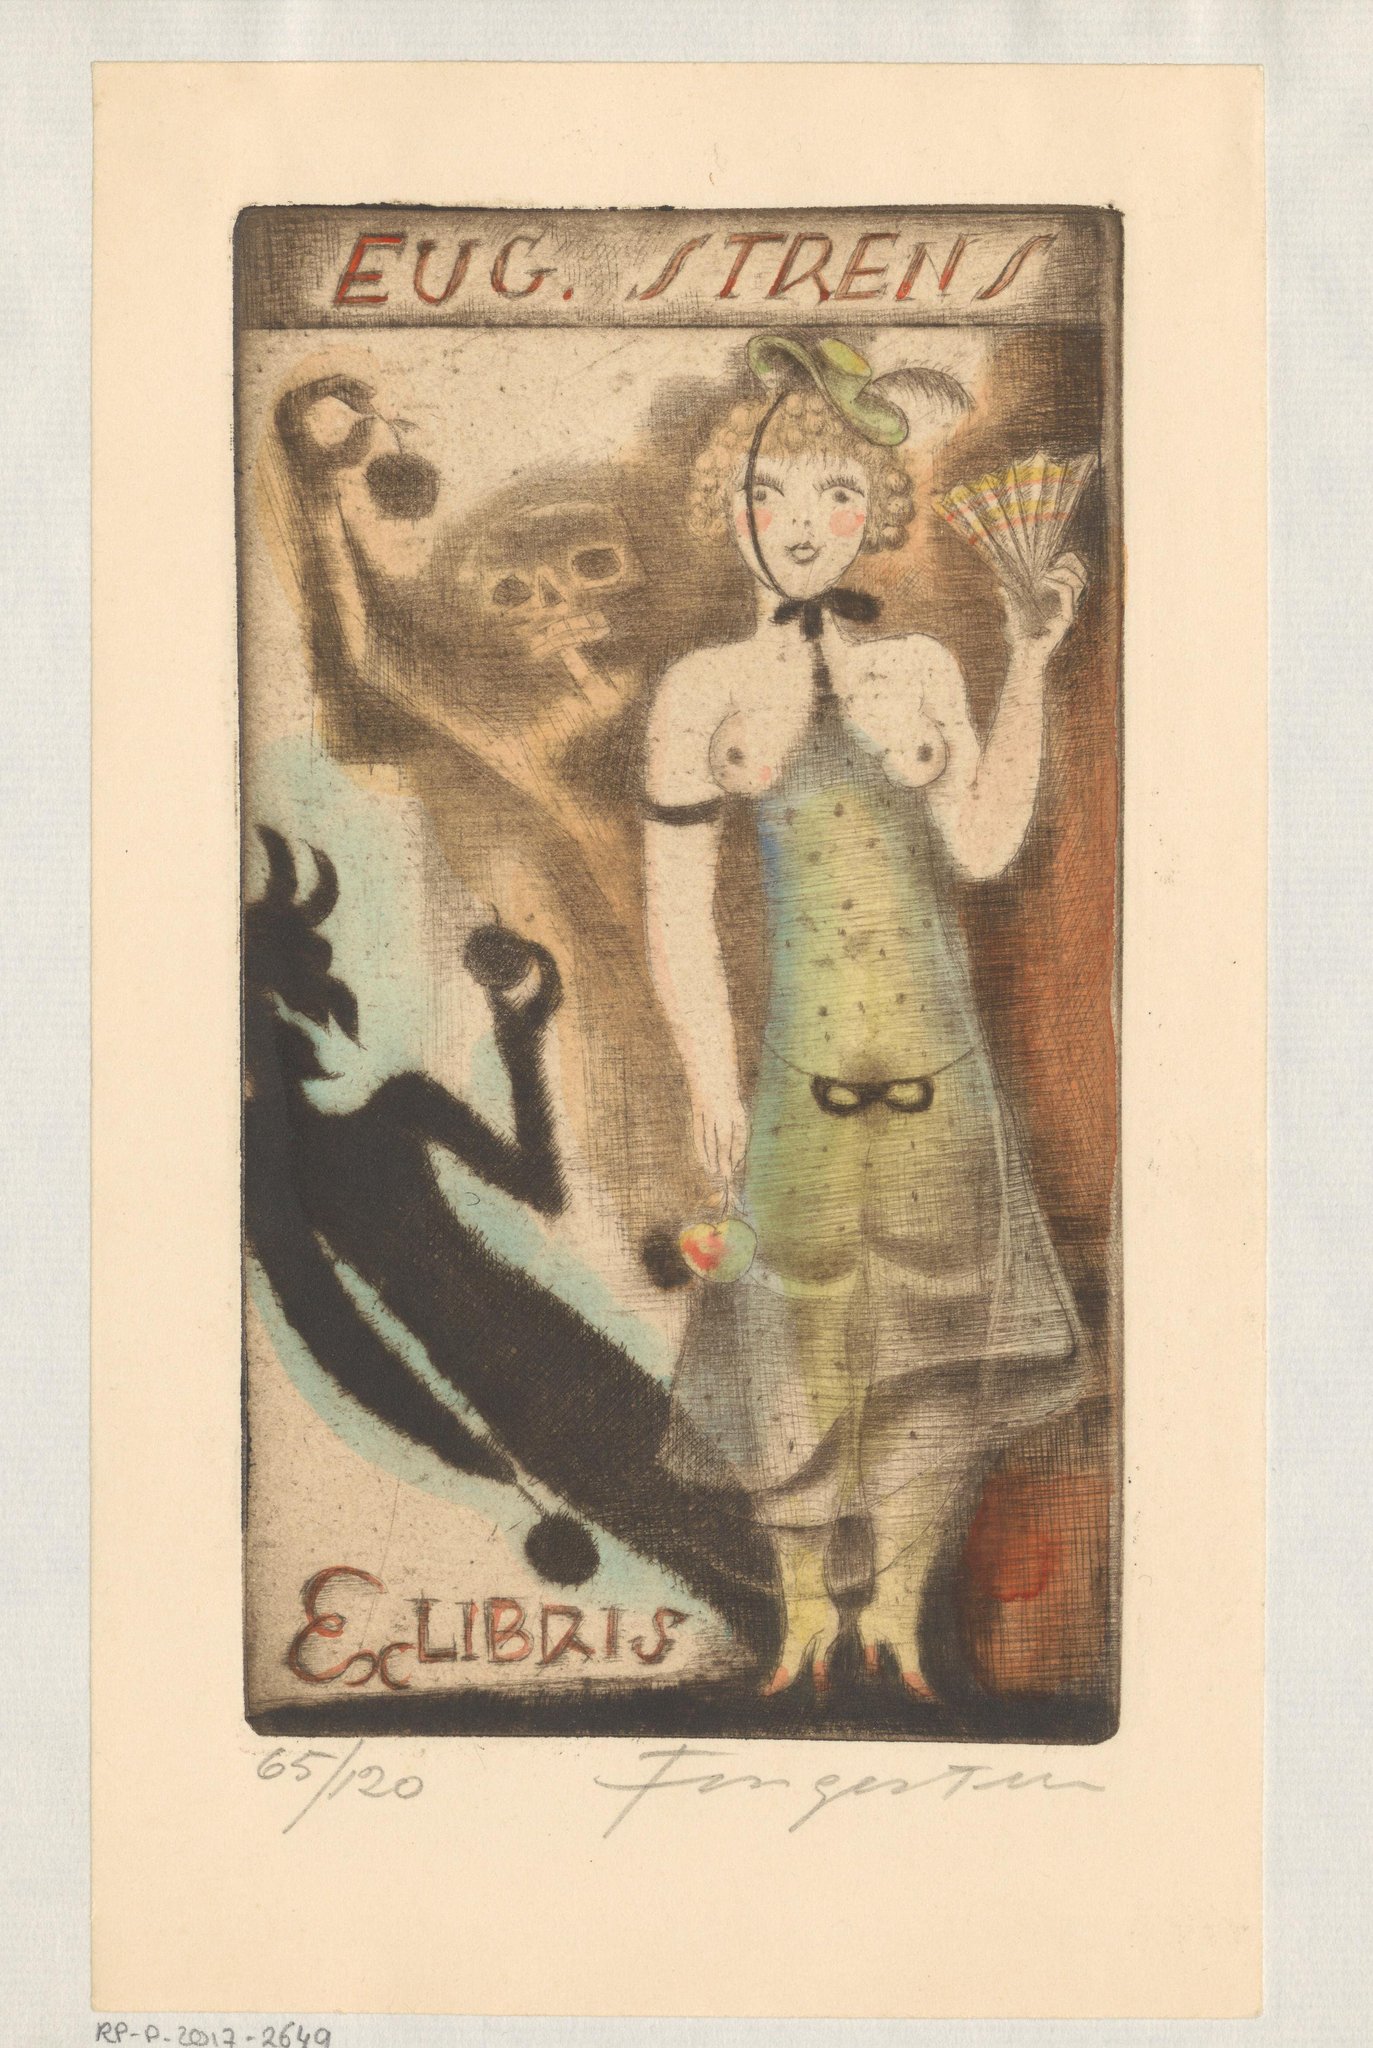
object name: bookplate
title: Ex libris van Eug. Strens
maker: michel fingesten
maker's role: painter, print maker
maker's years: 1884-1943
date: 1894-1943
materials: paper, watercolor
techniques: etching, hand coloring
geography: italy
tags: engineer, eugène louis charles marie strens, fruits: apple, death as skeleton, devil(s) and demons, woman (showing herself) undressed, quasi-nude, fan, whore, prostitute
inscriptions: workshop stamp: ‘Michel Fingesten’, signature: ‘65/120 Fingesten’, inscription: ‘met de hand gekleurd!’